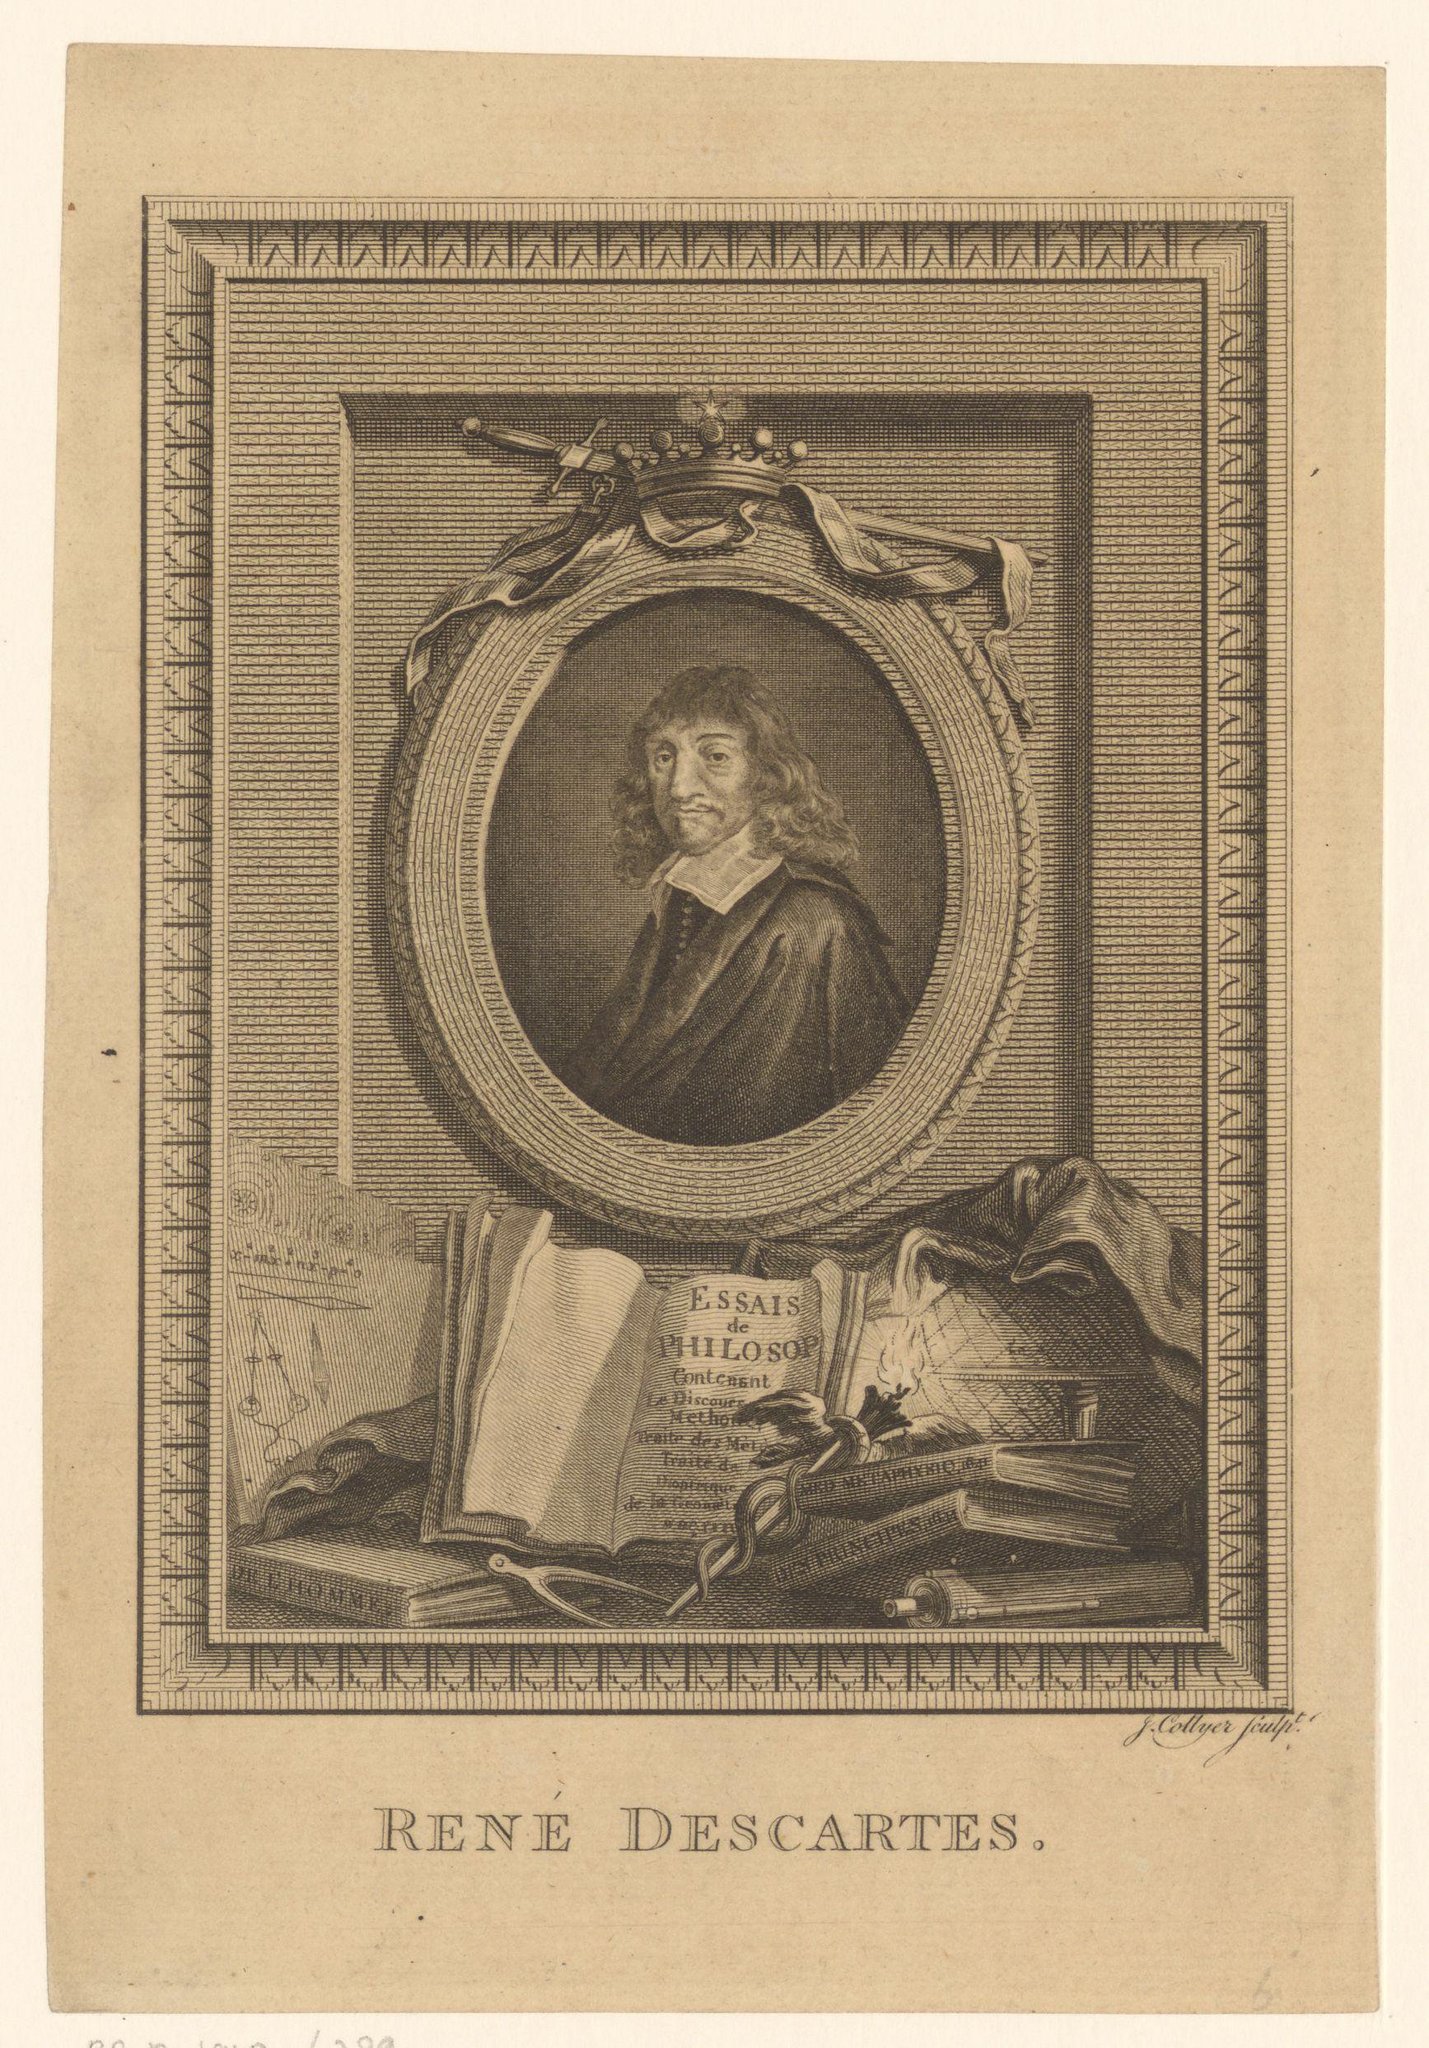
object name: print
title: Portret van René Descartes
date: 1758-1775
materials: paper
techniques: engraving, etching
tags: rené descartes, historical persons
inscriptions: collector's mark: Lugt 2228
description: Prent gebruikt in: The Copper-Plate Magazine or A Monthly Treasure (1775).